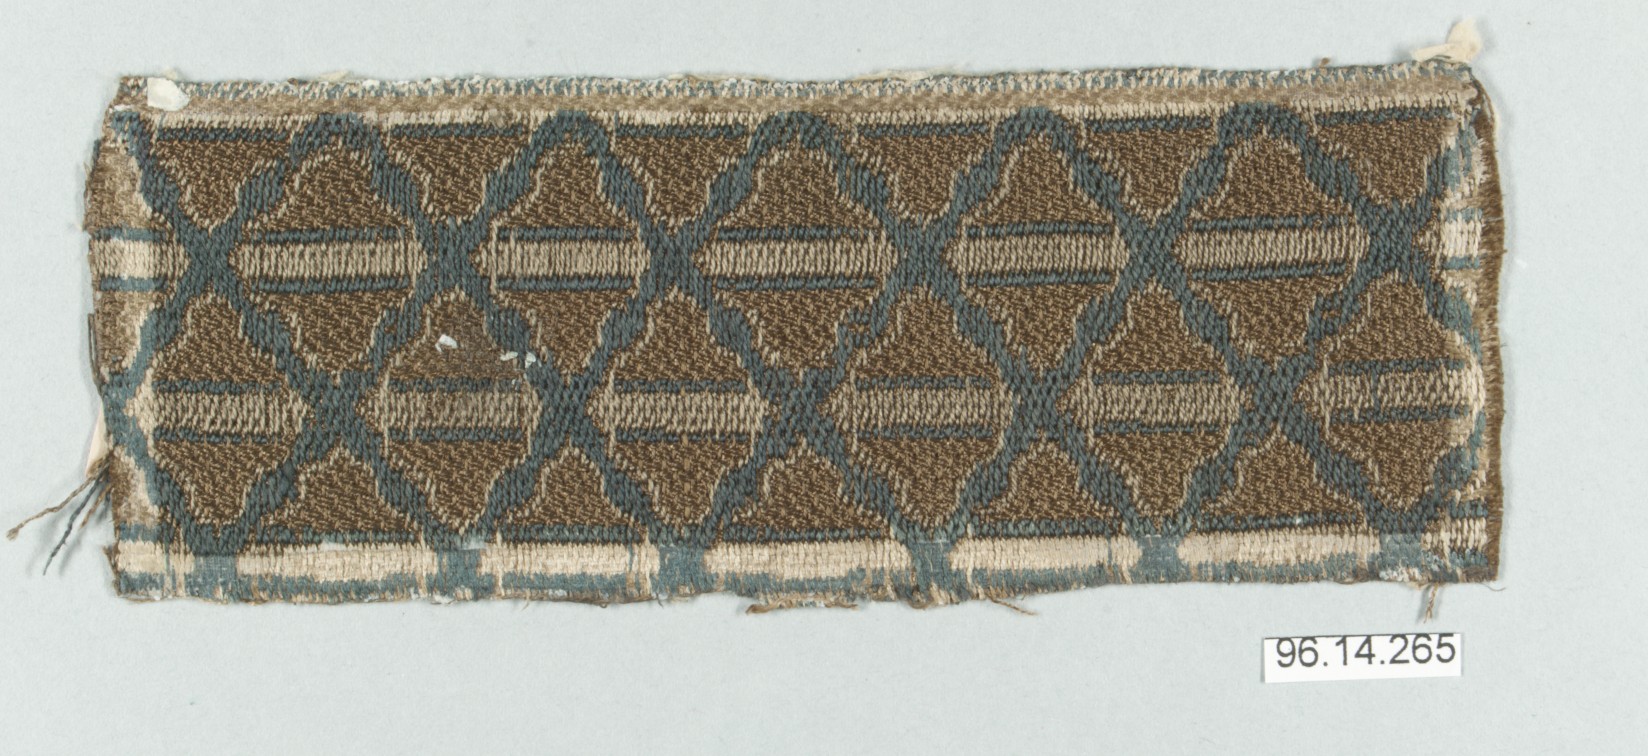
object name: piece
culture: japanese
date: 1701-1900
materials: silk